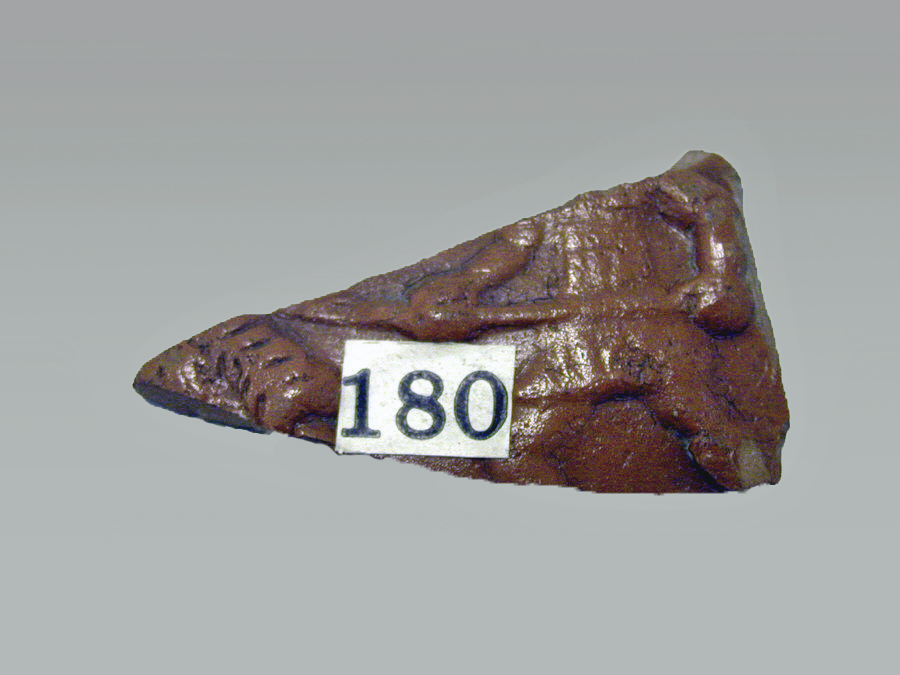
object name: vase fragment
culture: roman, gaul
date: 120 BCE-300 CE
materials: terracotta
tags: spears,men